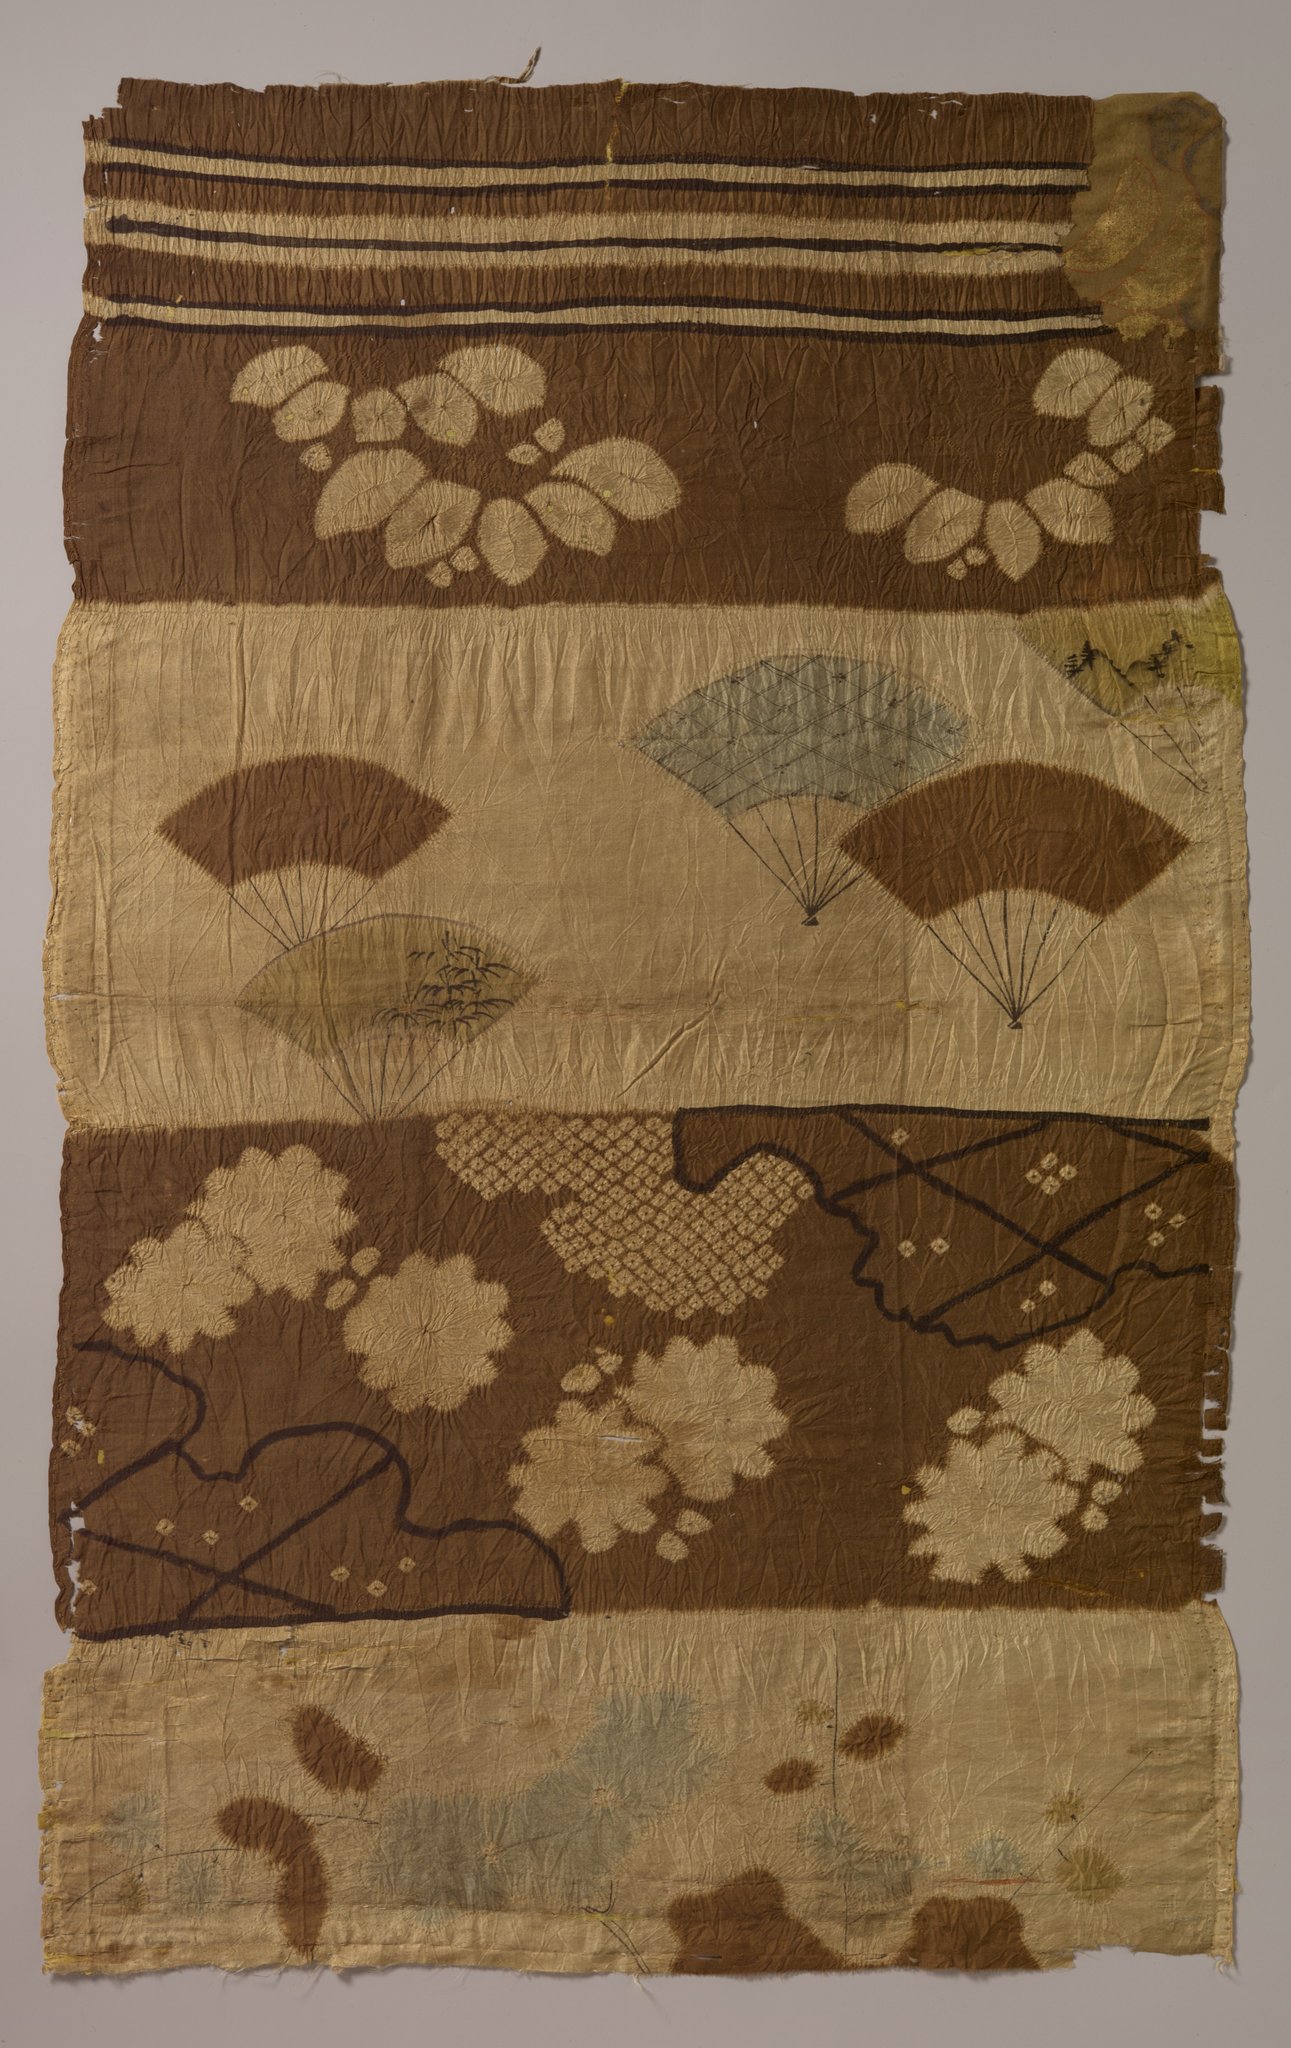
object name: piece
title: Tsujigahana Textile with Horizontal Stripes, Flowering Plants, Fans, Snowflakes, Clouds, and Bellflowers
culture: japanese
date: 1567-1600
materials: ink, silk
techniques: painting, weave, resist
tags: fans,flowers